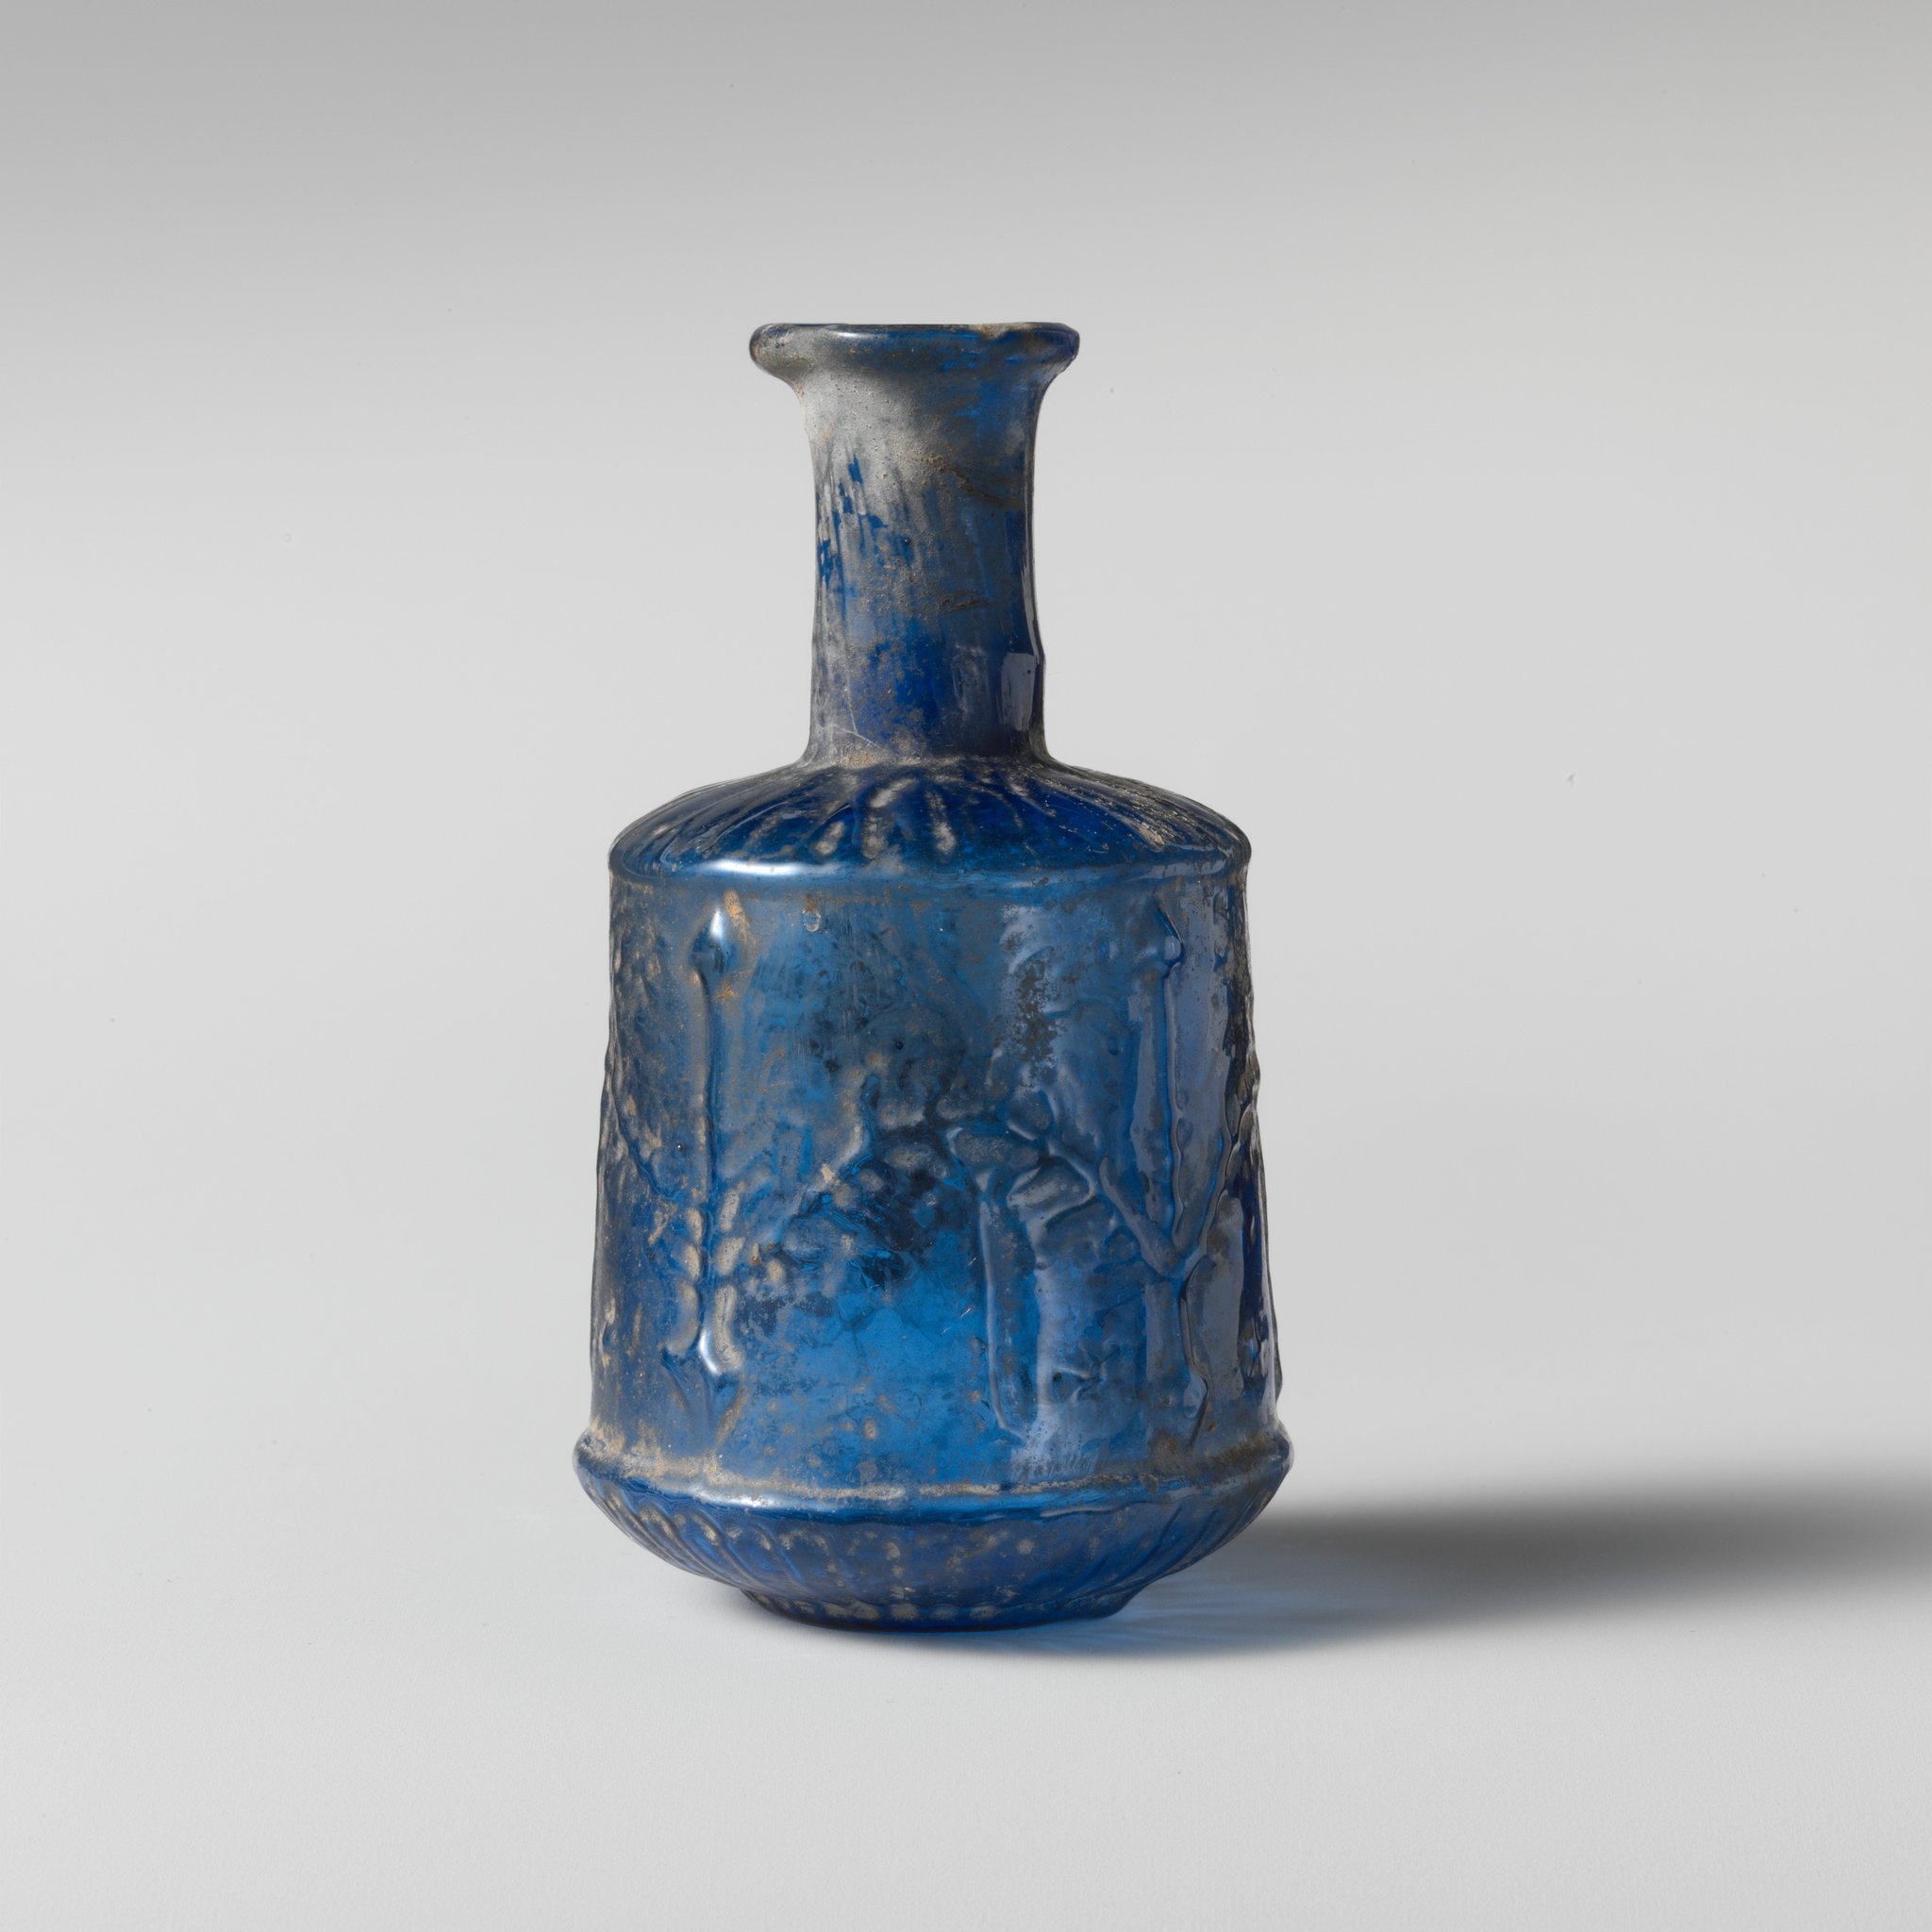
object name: bottle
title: Glass bottle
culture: roman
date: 1-100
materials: glass